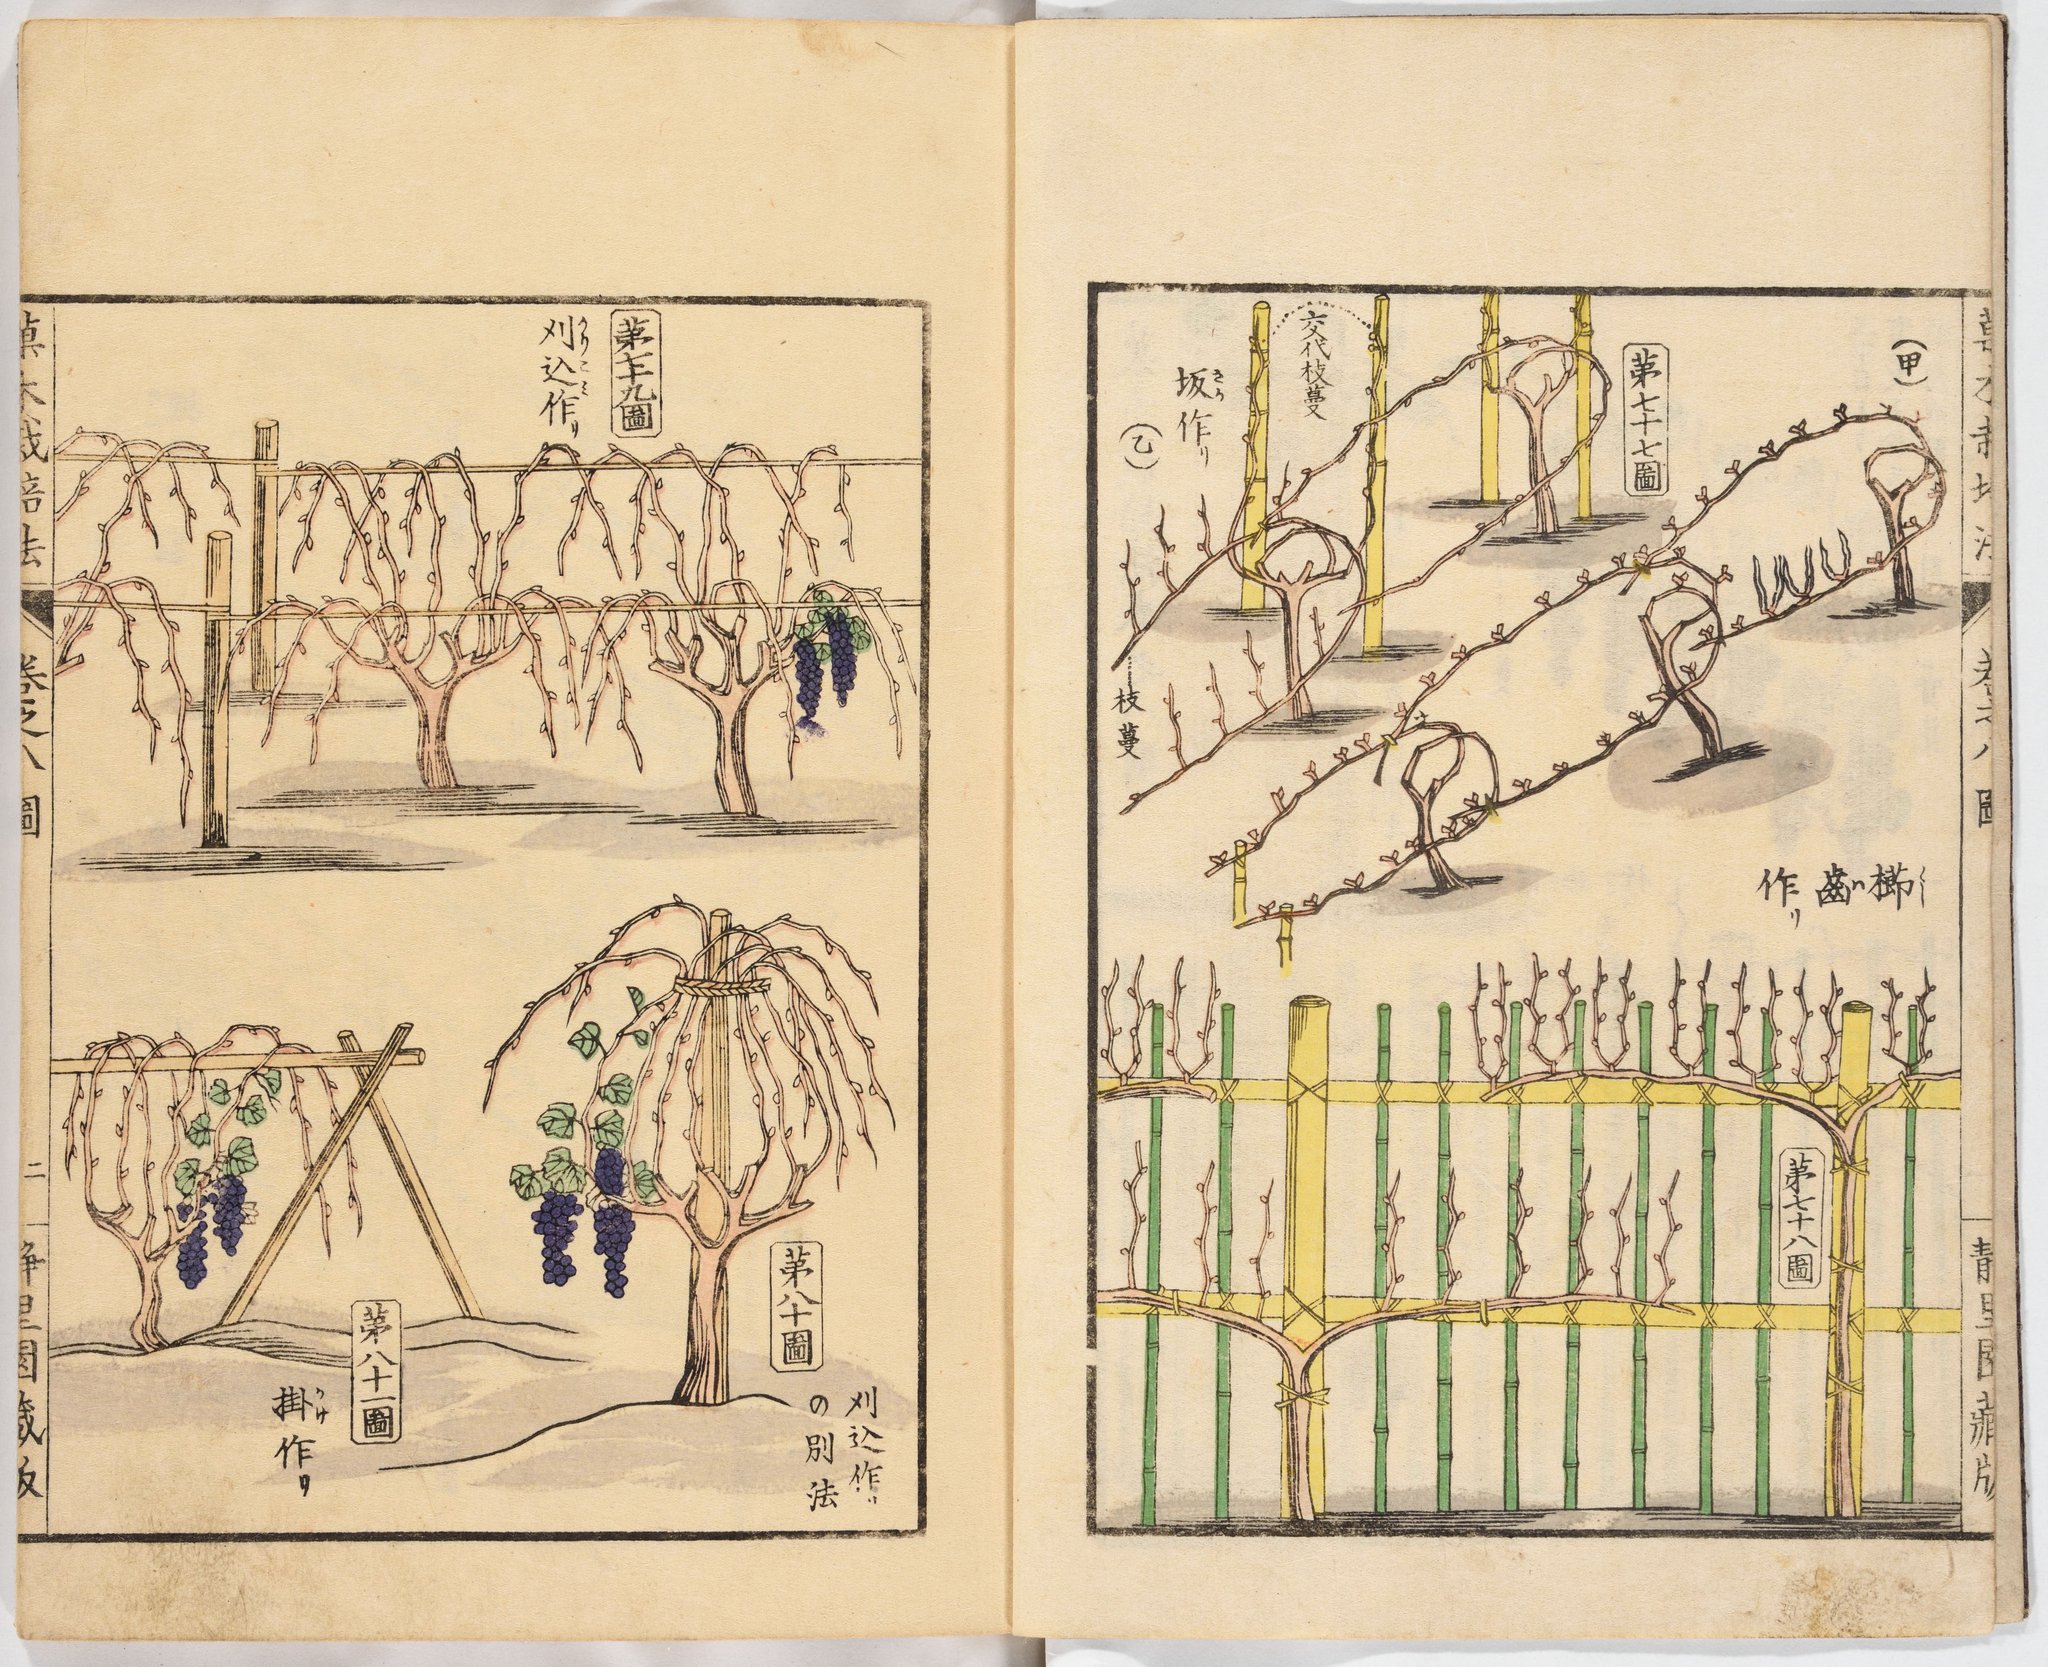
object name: illustrated book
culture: japanese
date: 1893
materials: ink, paper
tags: fences,grapes,trees